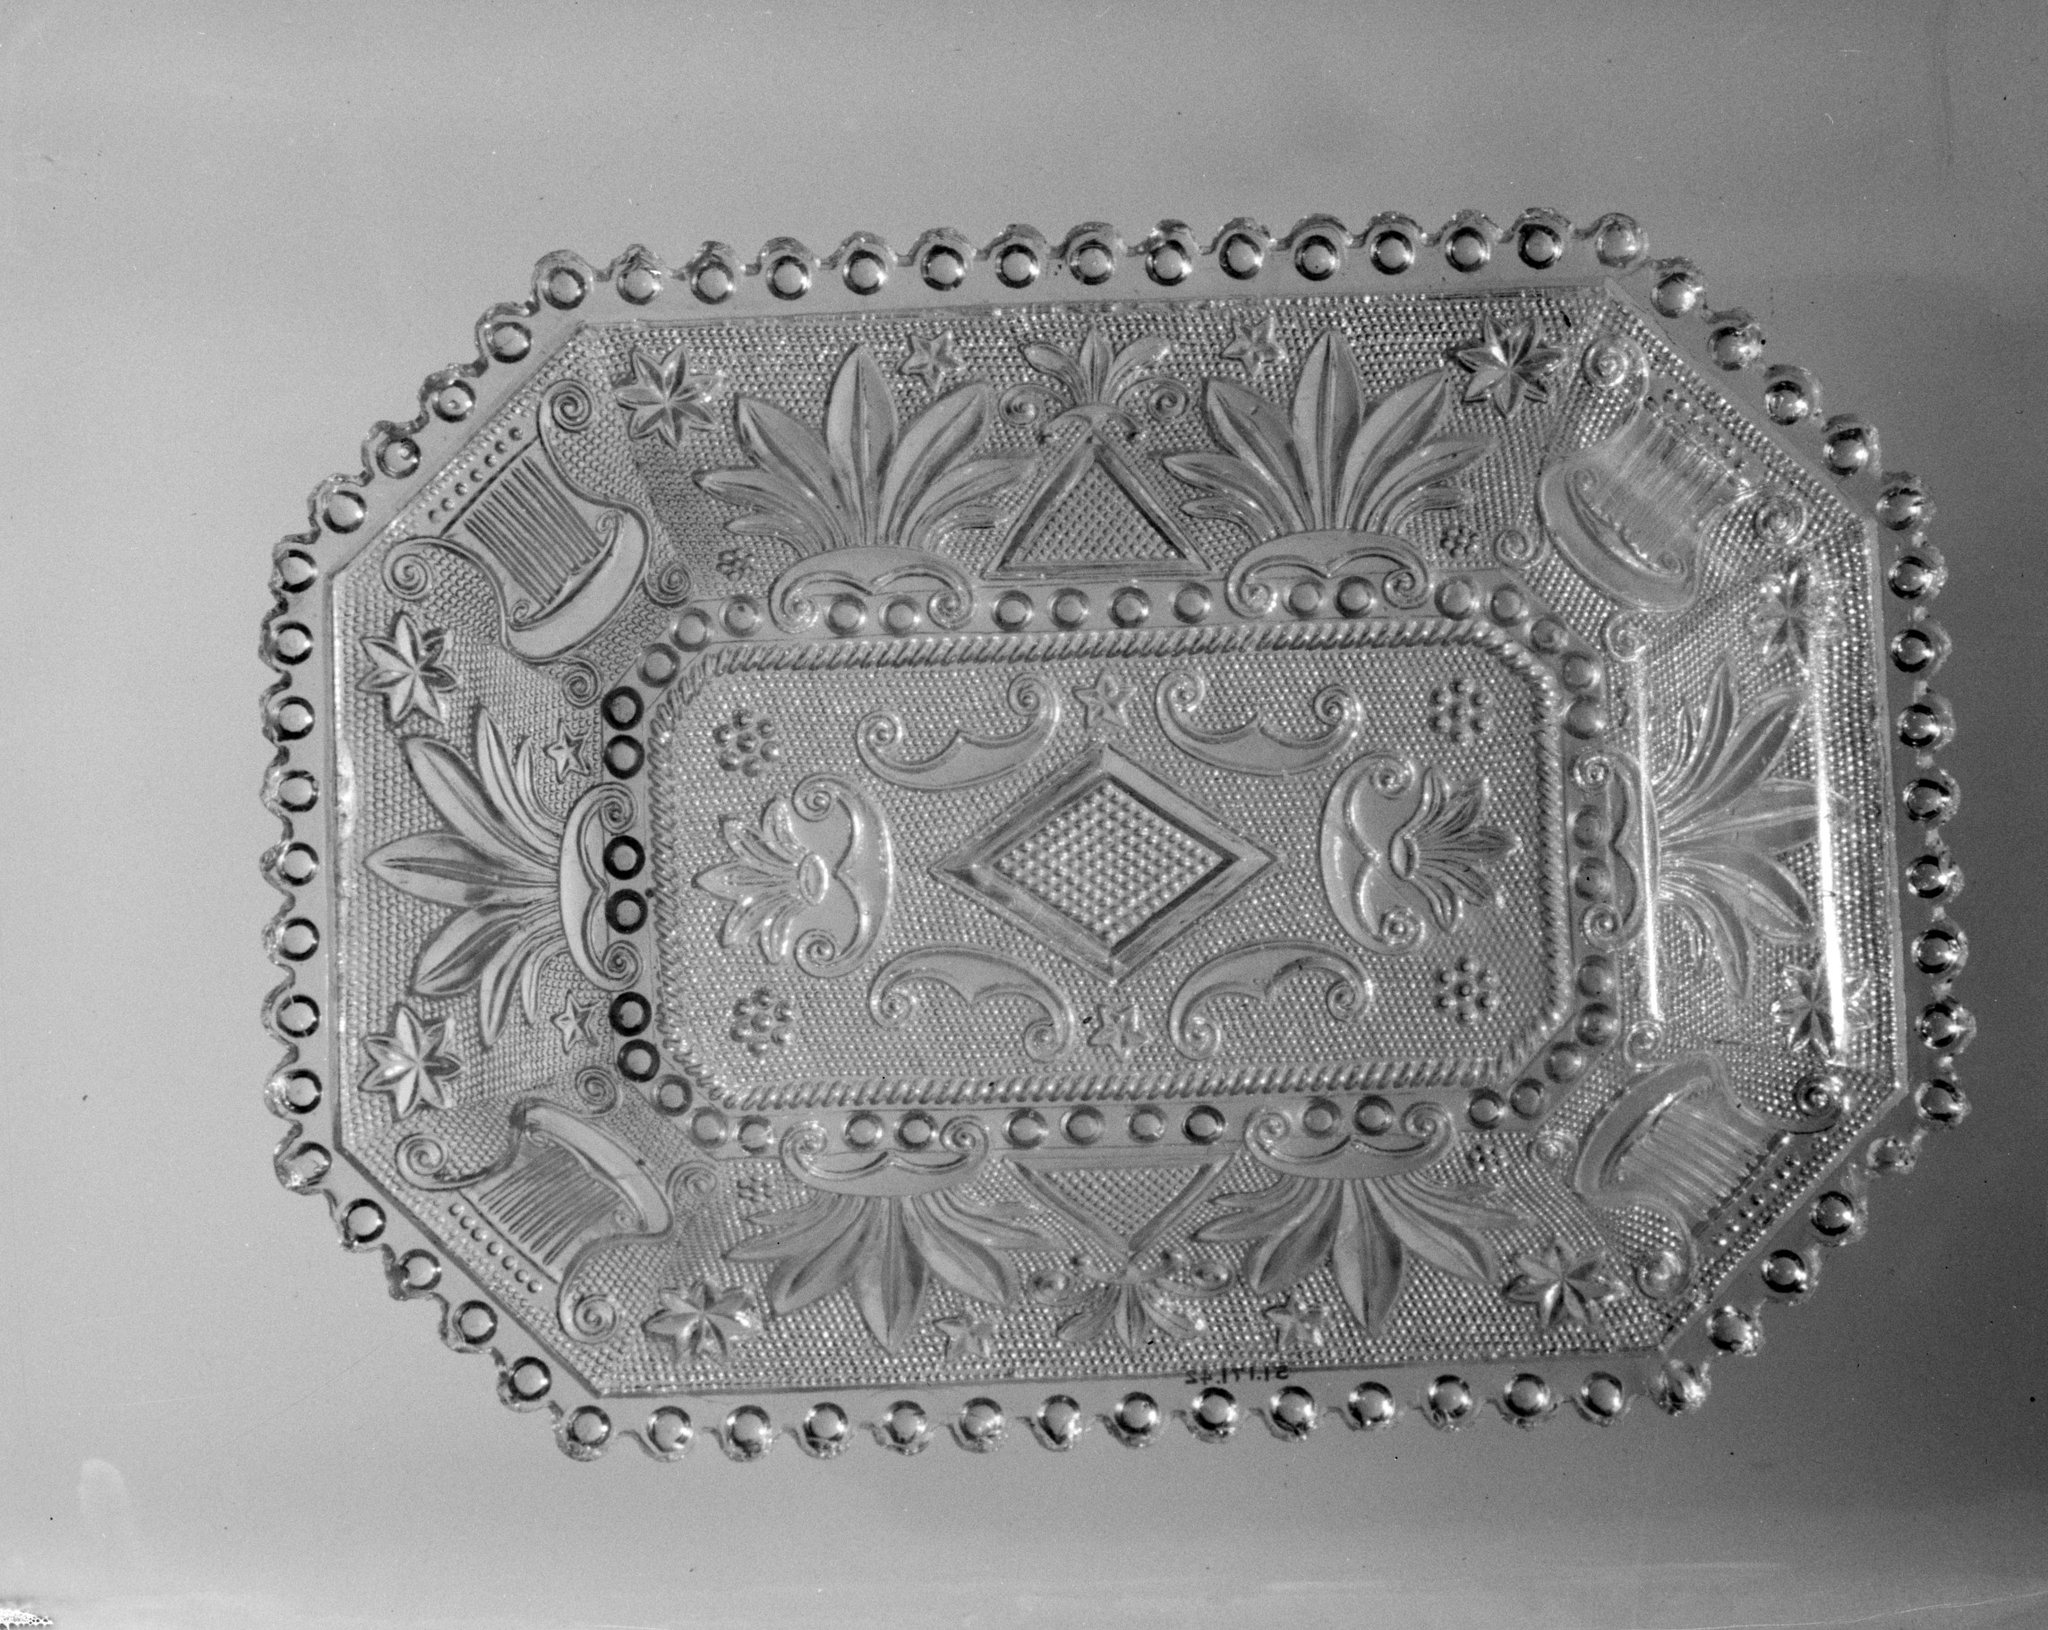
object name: dish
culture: american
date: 1835-1850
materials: glass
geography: united states